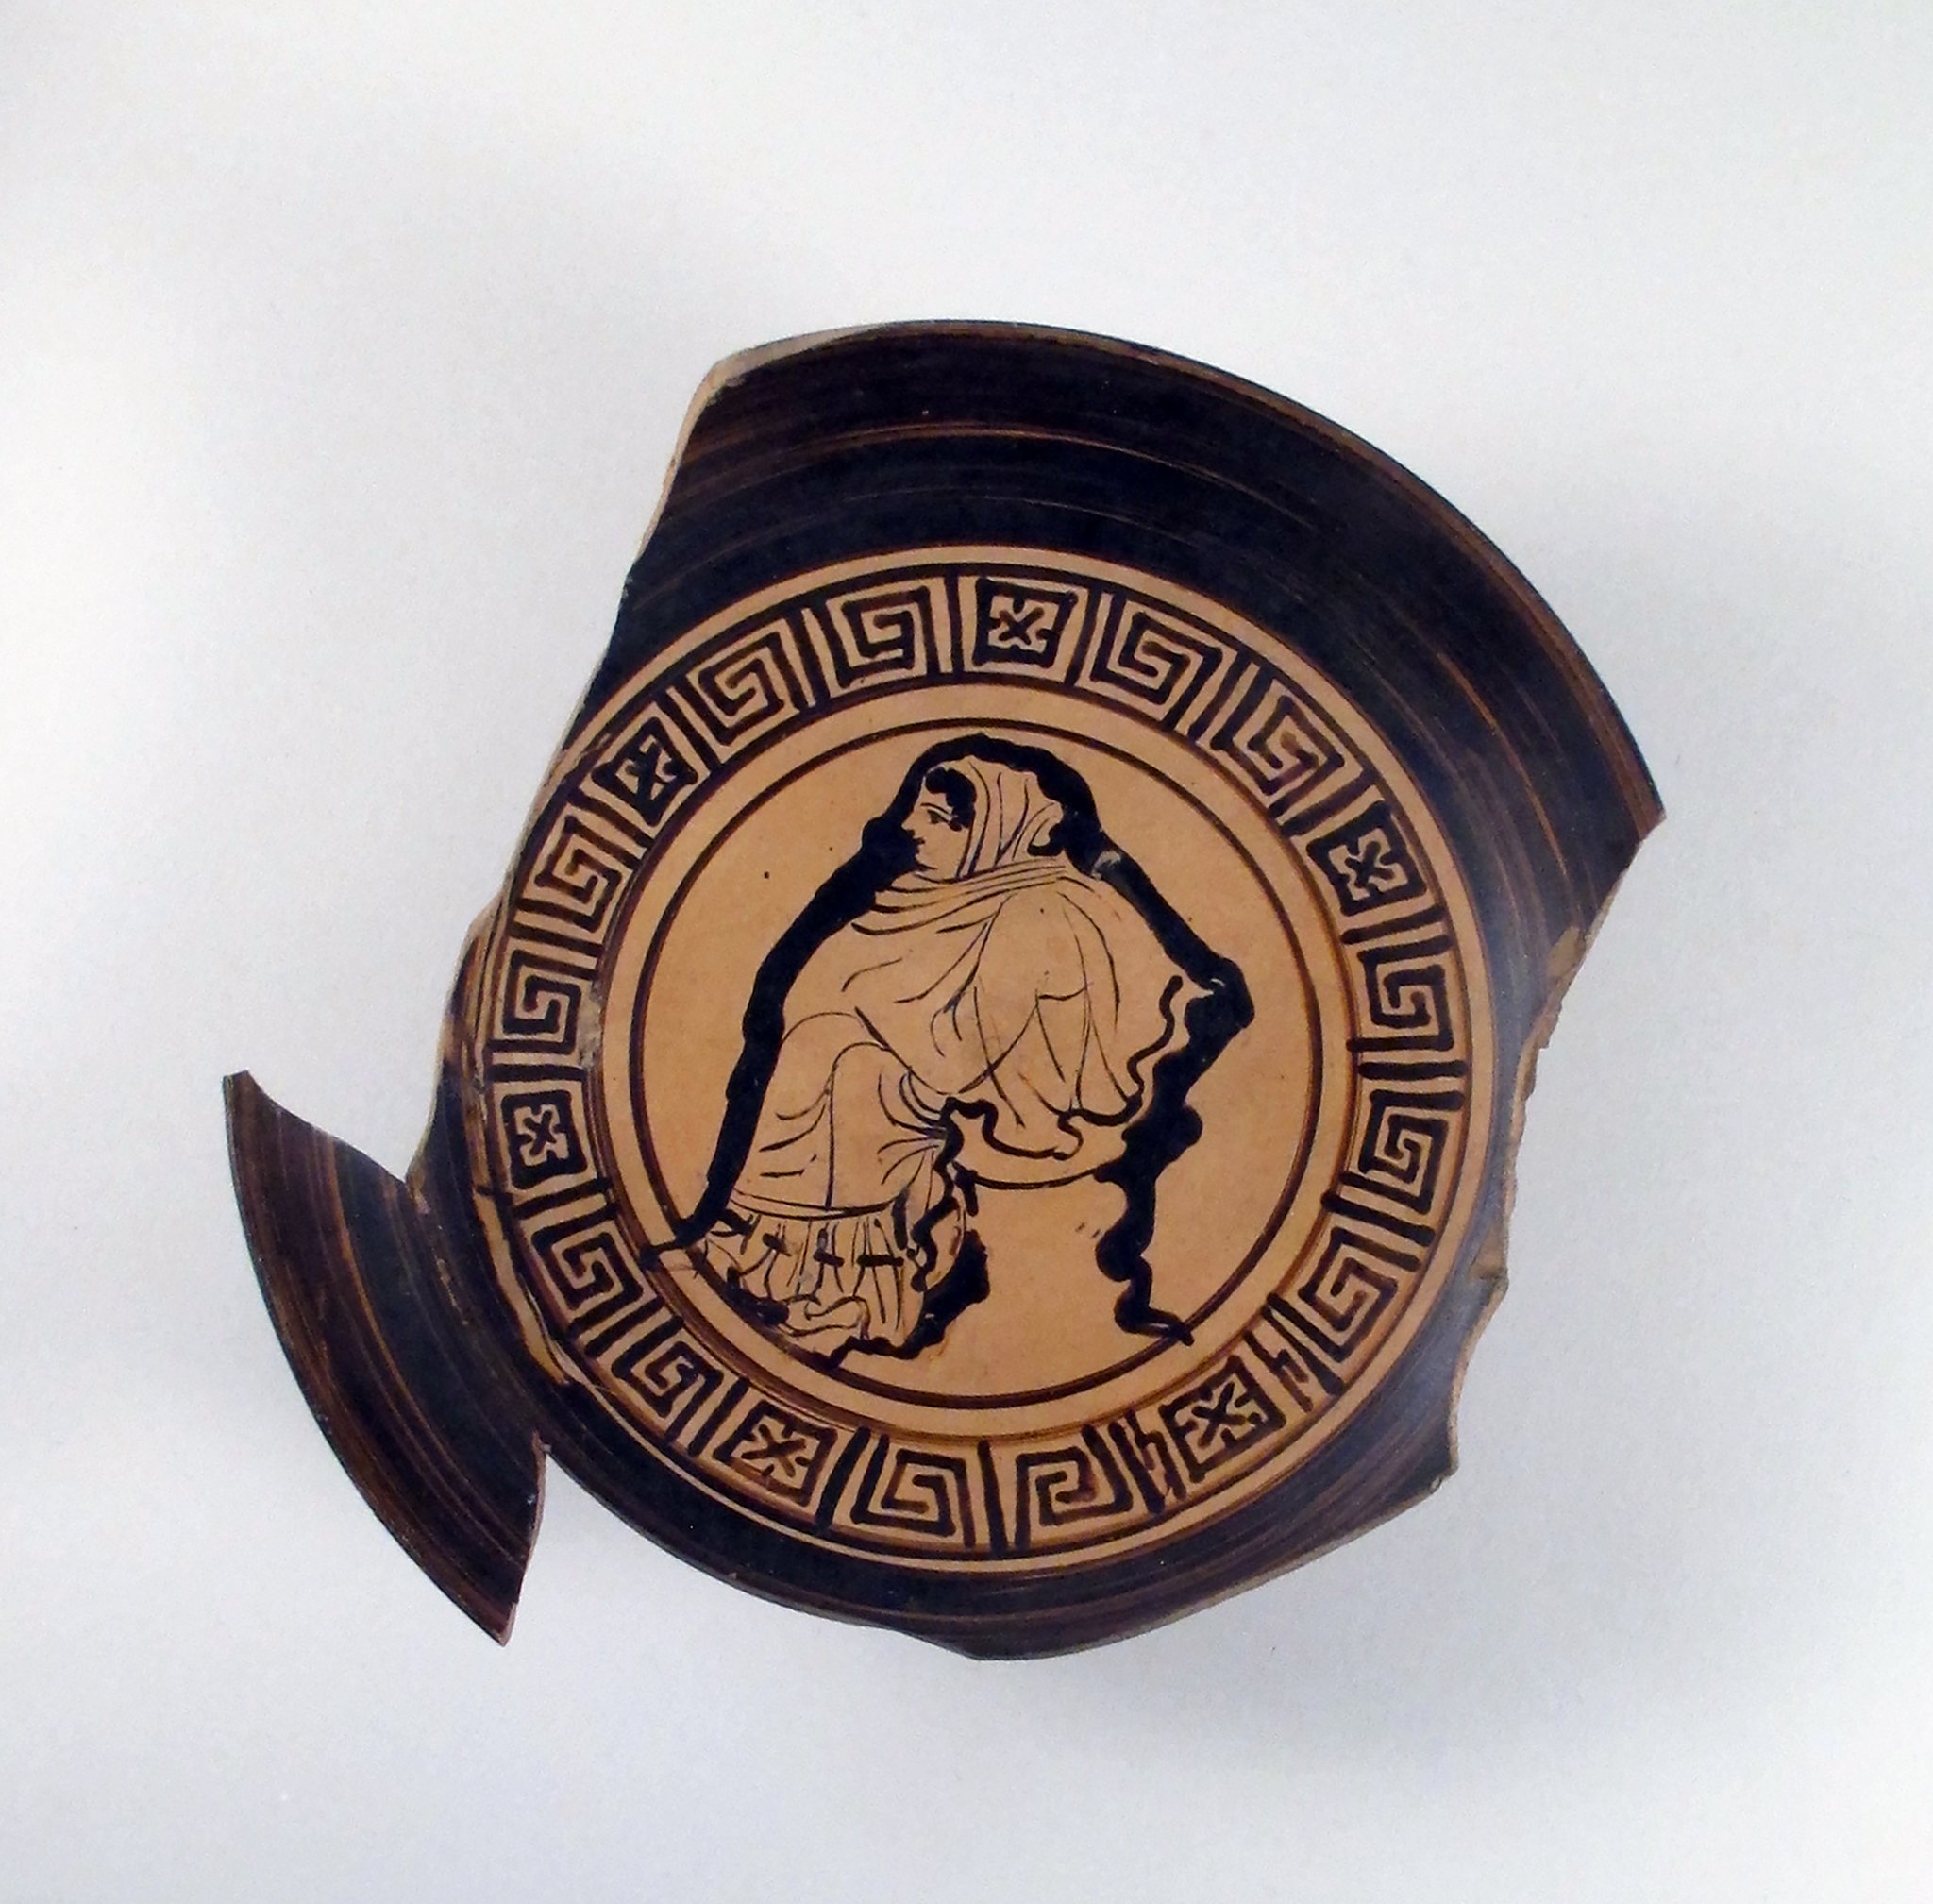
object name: kylix fragment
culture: greek or south italian or campanian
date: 7000-30 BCE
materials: terracotta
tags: women